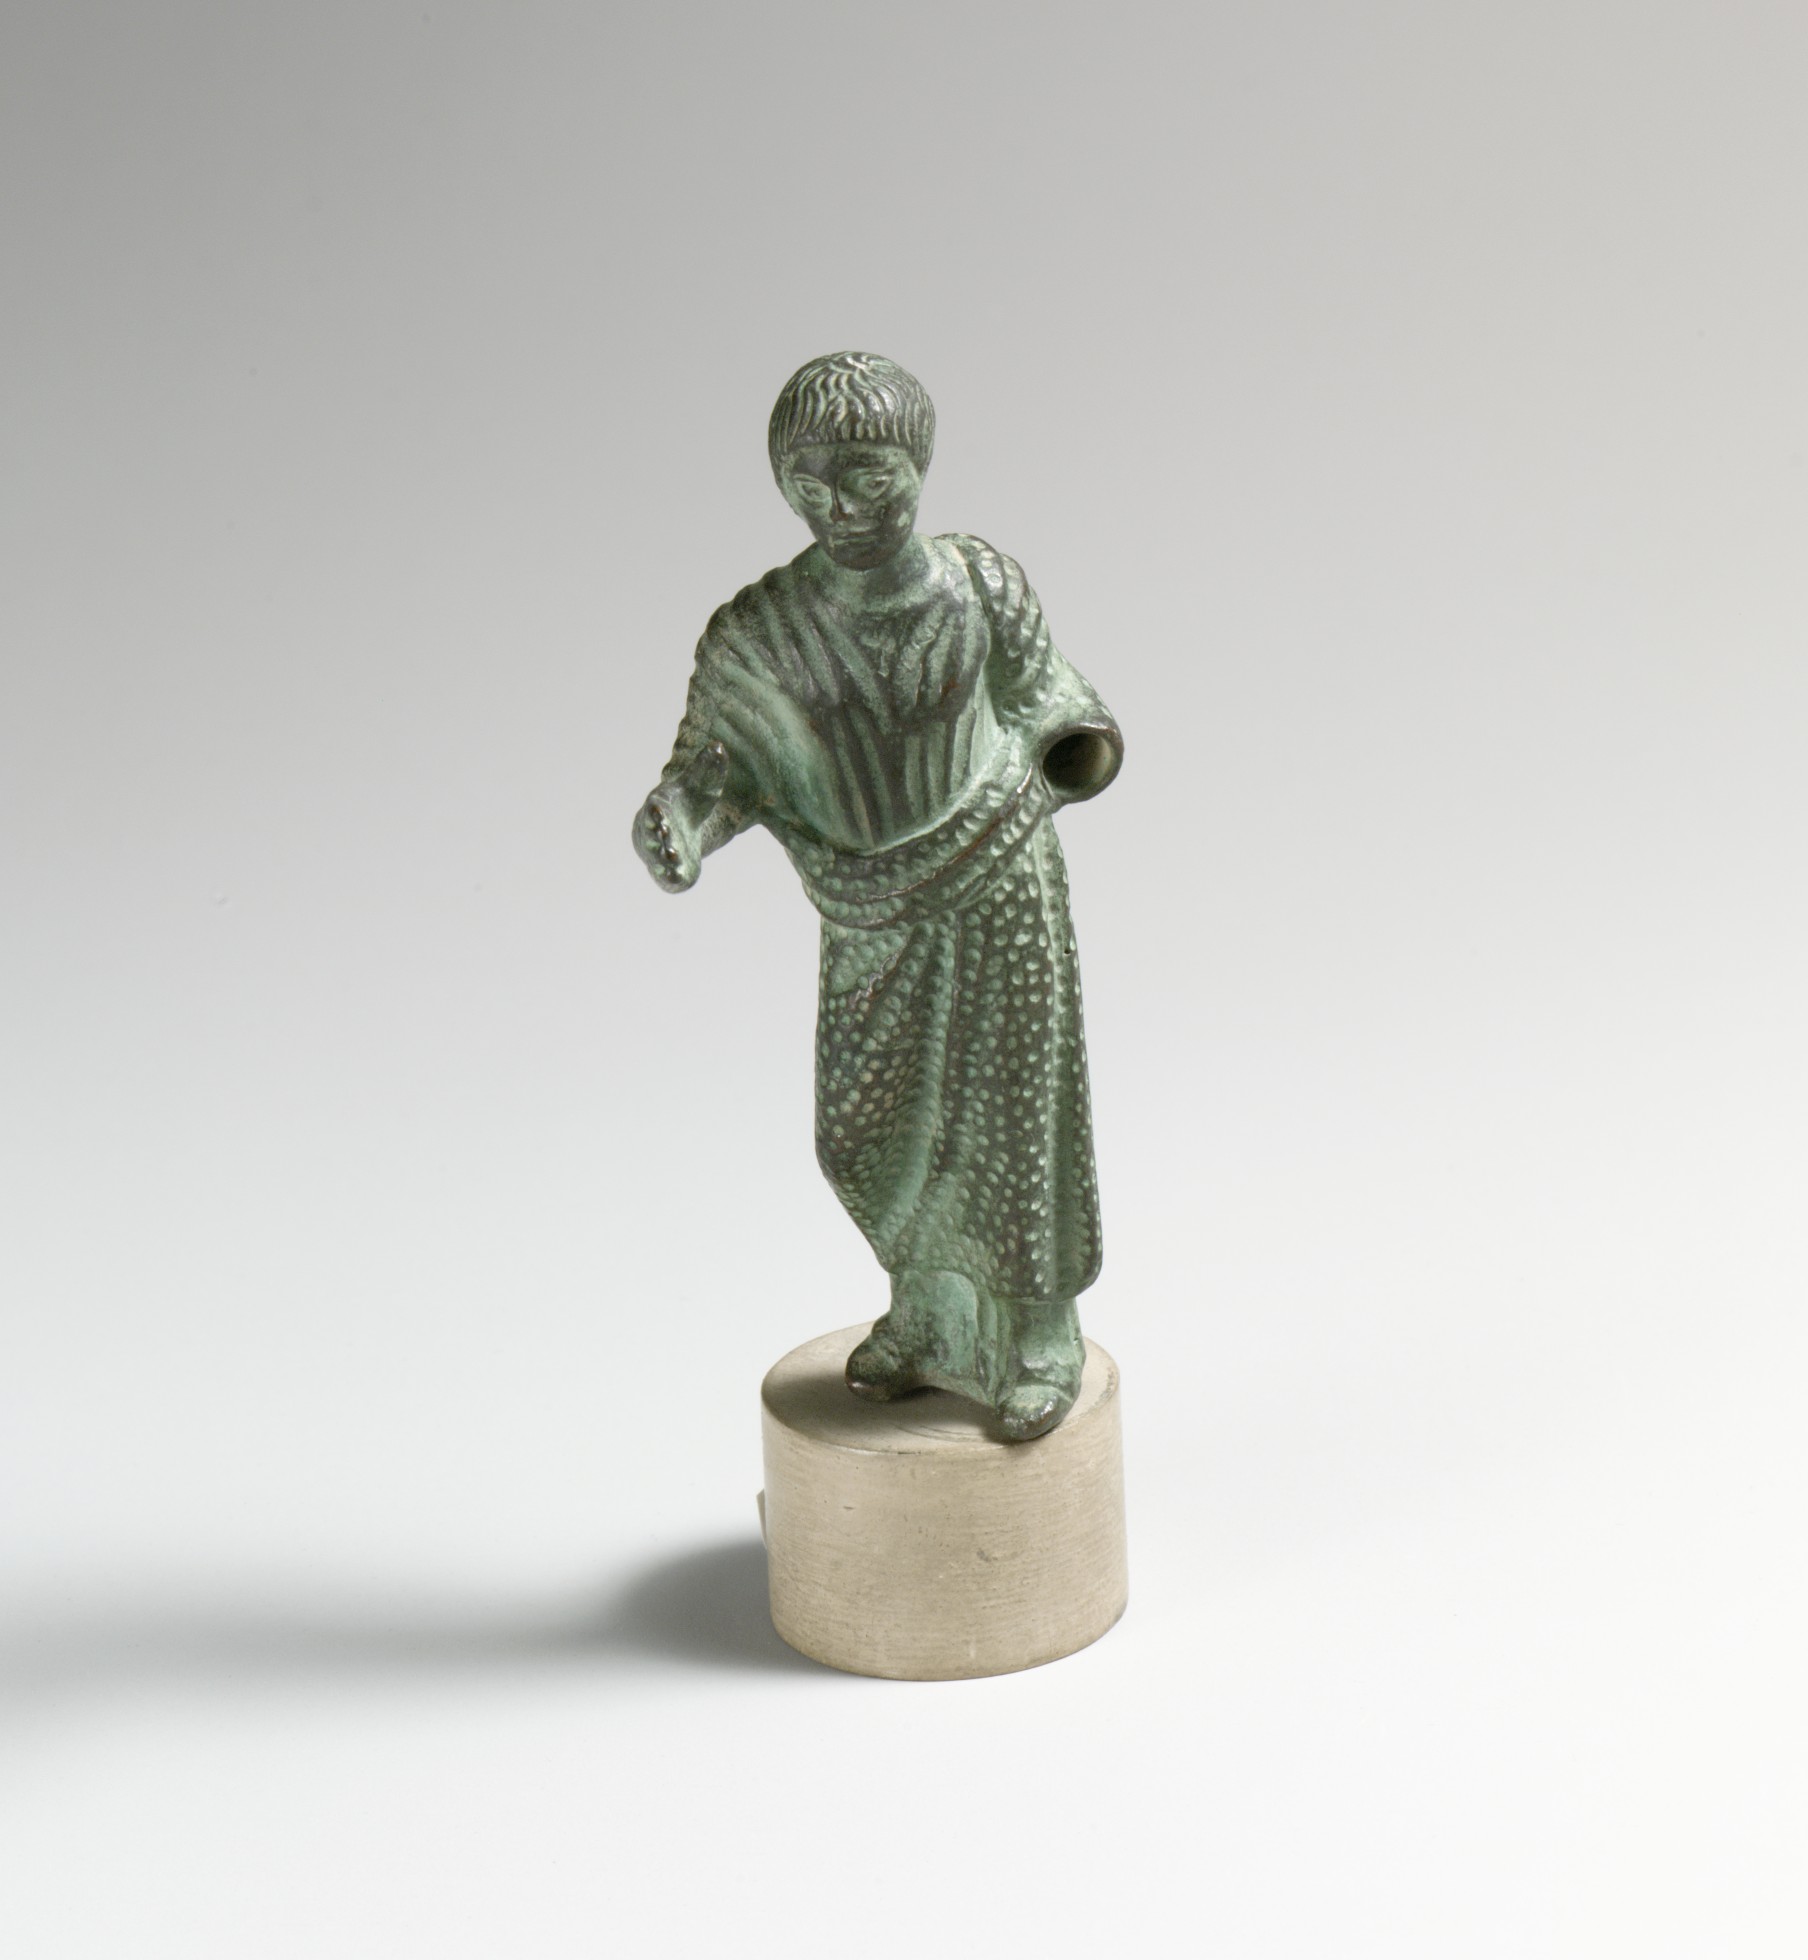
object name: statuette of an orator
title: Bronze statuette of a man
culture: roman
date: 1-200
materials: bronze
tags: men